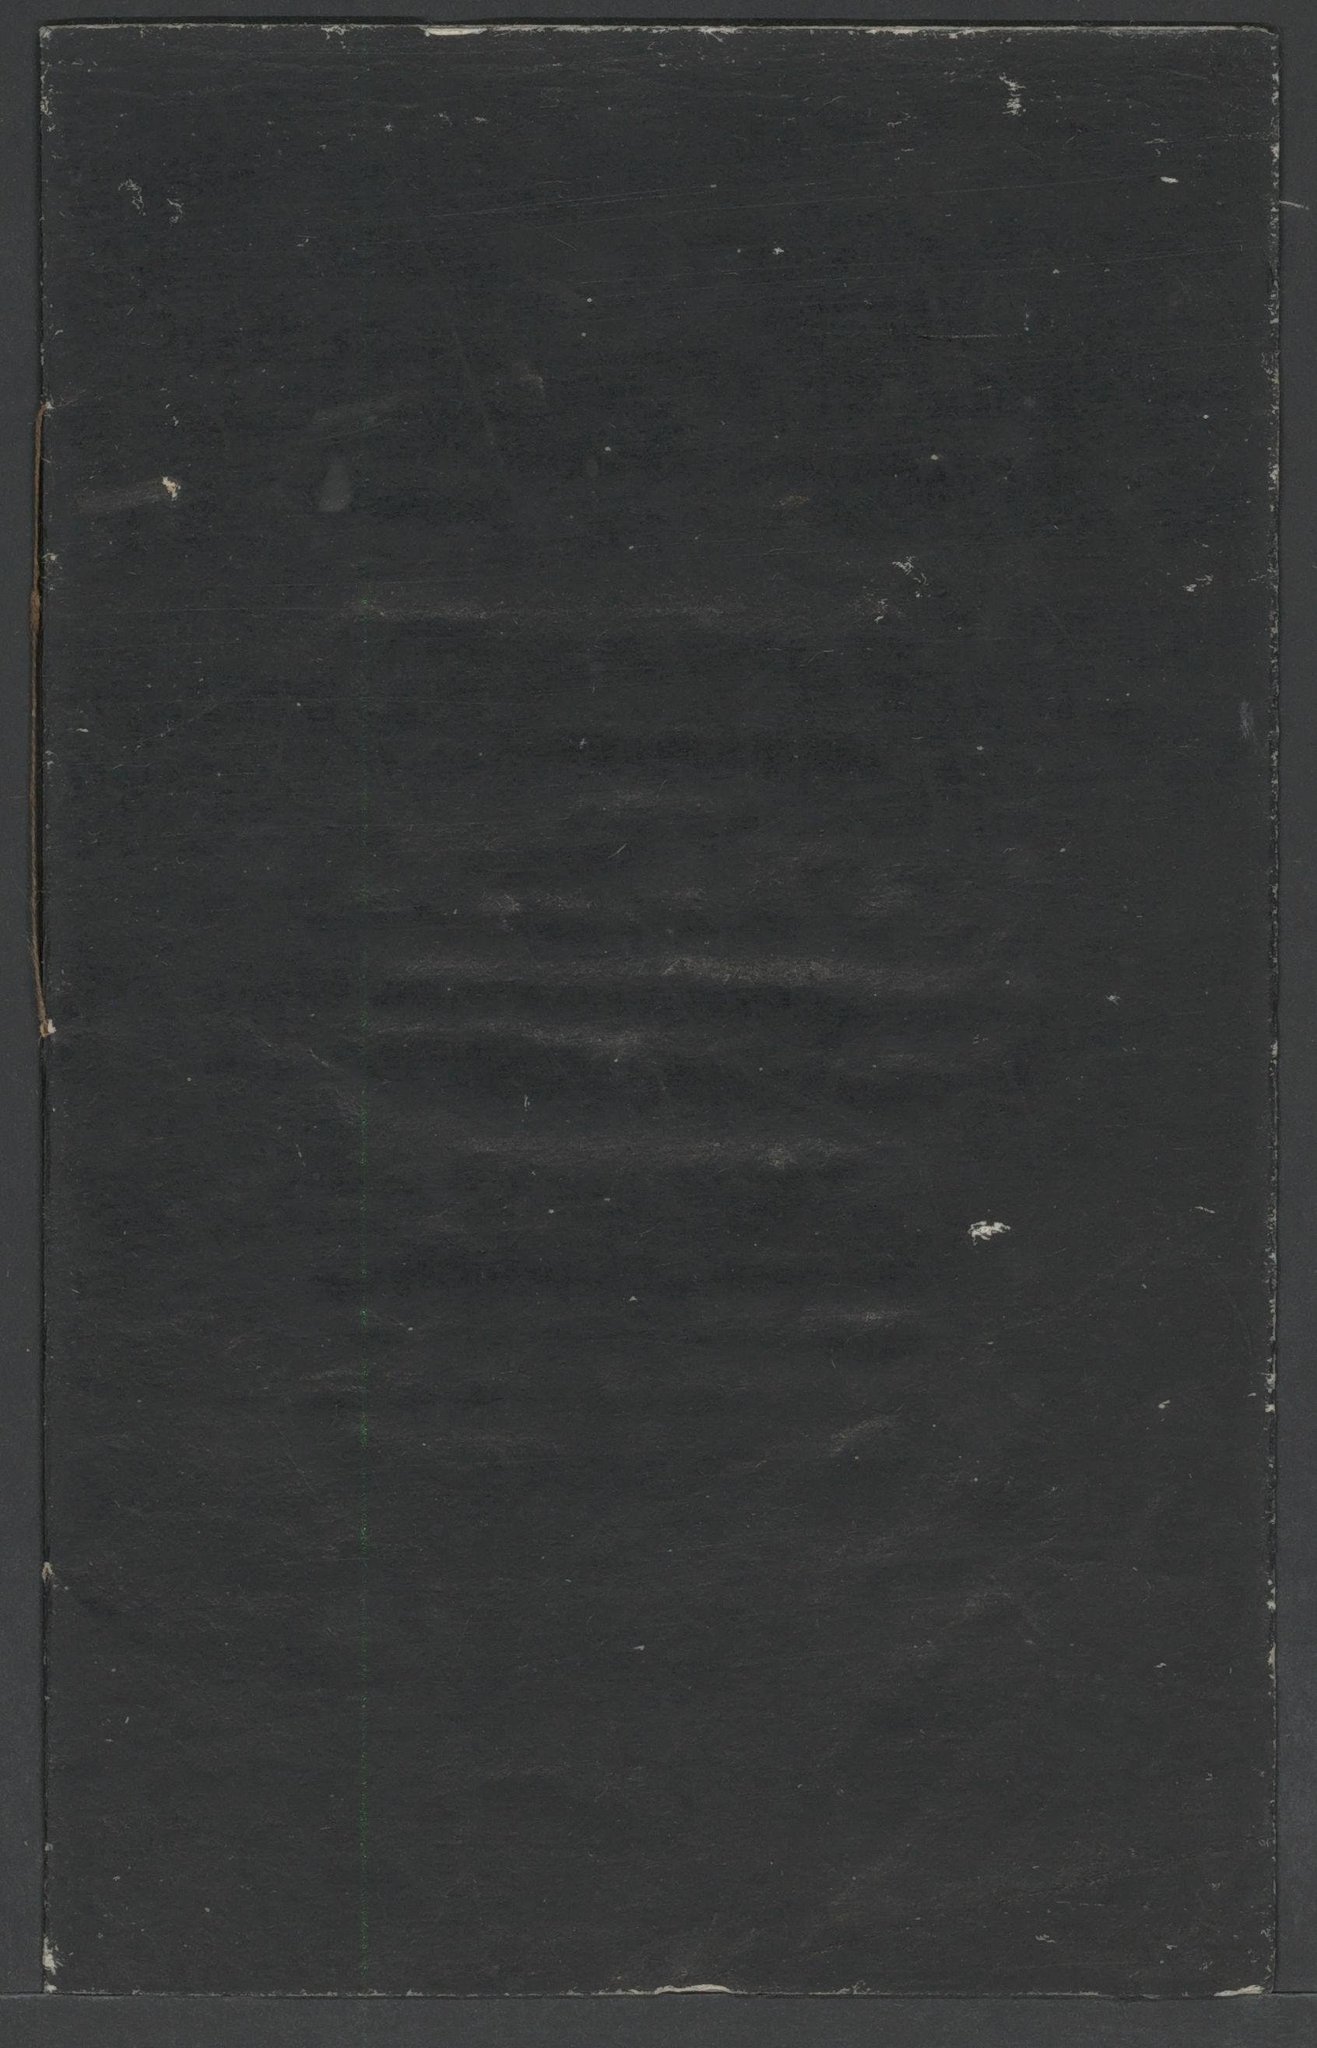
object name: text sheet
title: Lijkklagt bij den dood van den heer Isaäk de Wit Jz. Overleden den 13 Maart 1809. Toegewijd aan zijn Ed. Wed. Mejufffrouw E.M. de With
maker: visser bender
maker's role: dichter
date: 1803-1809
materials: paper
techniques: letterpress printing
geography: netherlands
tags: amsterdam, haarlem, print maker, draughtsman, publisher, izaak jansz. de wit, mourning card, death notice, obituary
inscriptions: collector's mark: Lugt 1641, collector's mark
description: Boekje met gedicht bij het overlijden van Isaäk de Wit Jz. op 13 maart 1809, te Haarlem. Gebonden boekje van acht bladzijden, in een omslag van zwart papier. Onderwerpsrubrieken binnen de Atlas Zeden en Gewoonten: Des Menschen Begin, Midden en Einde. Begrafenissen, lijkzangen, grafschriften, pamfletten.